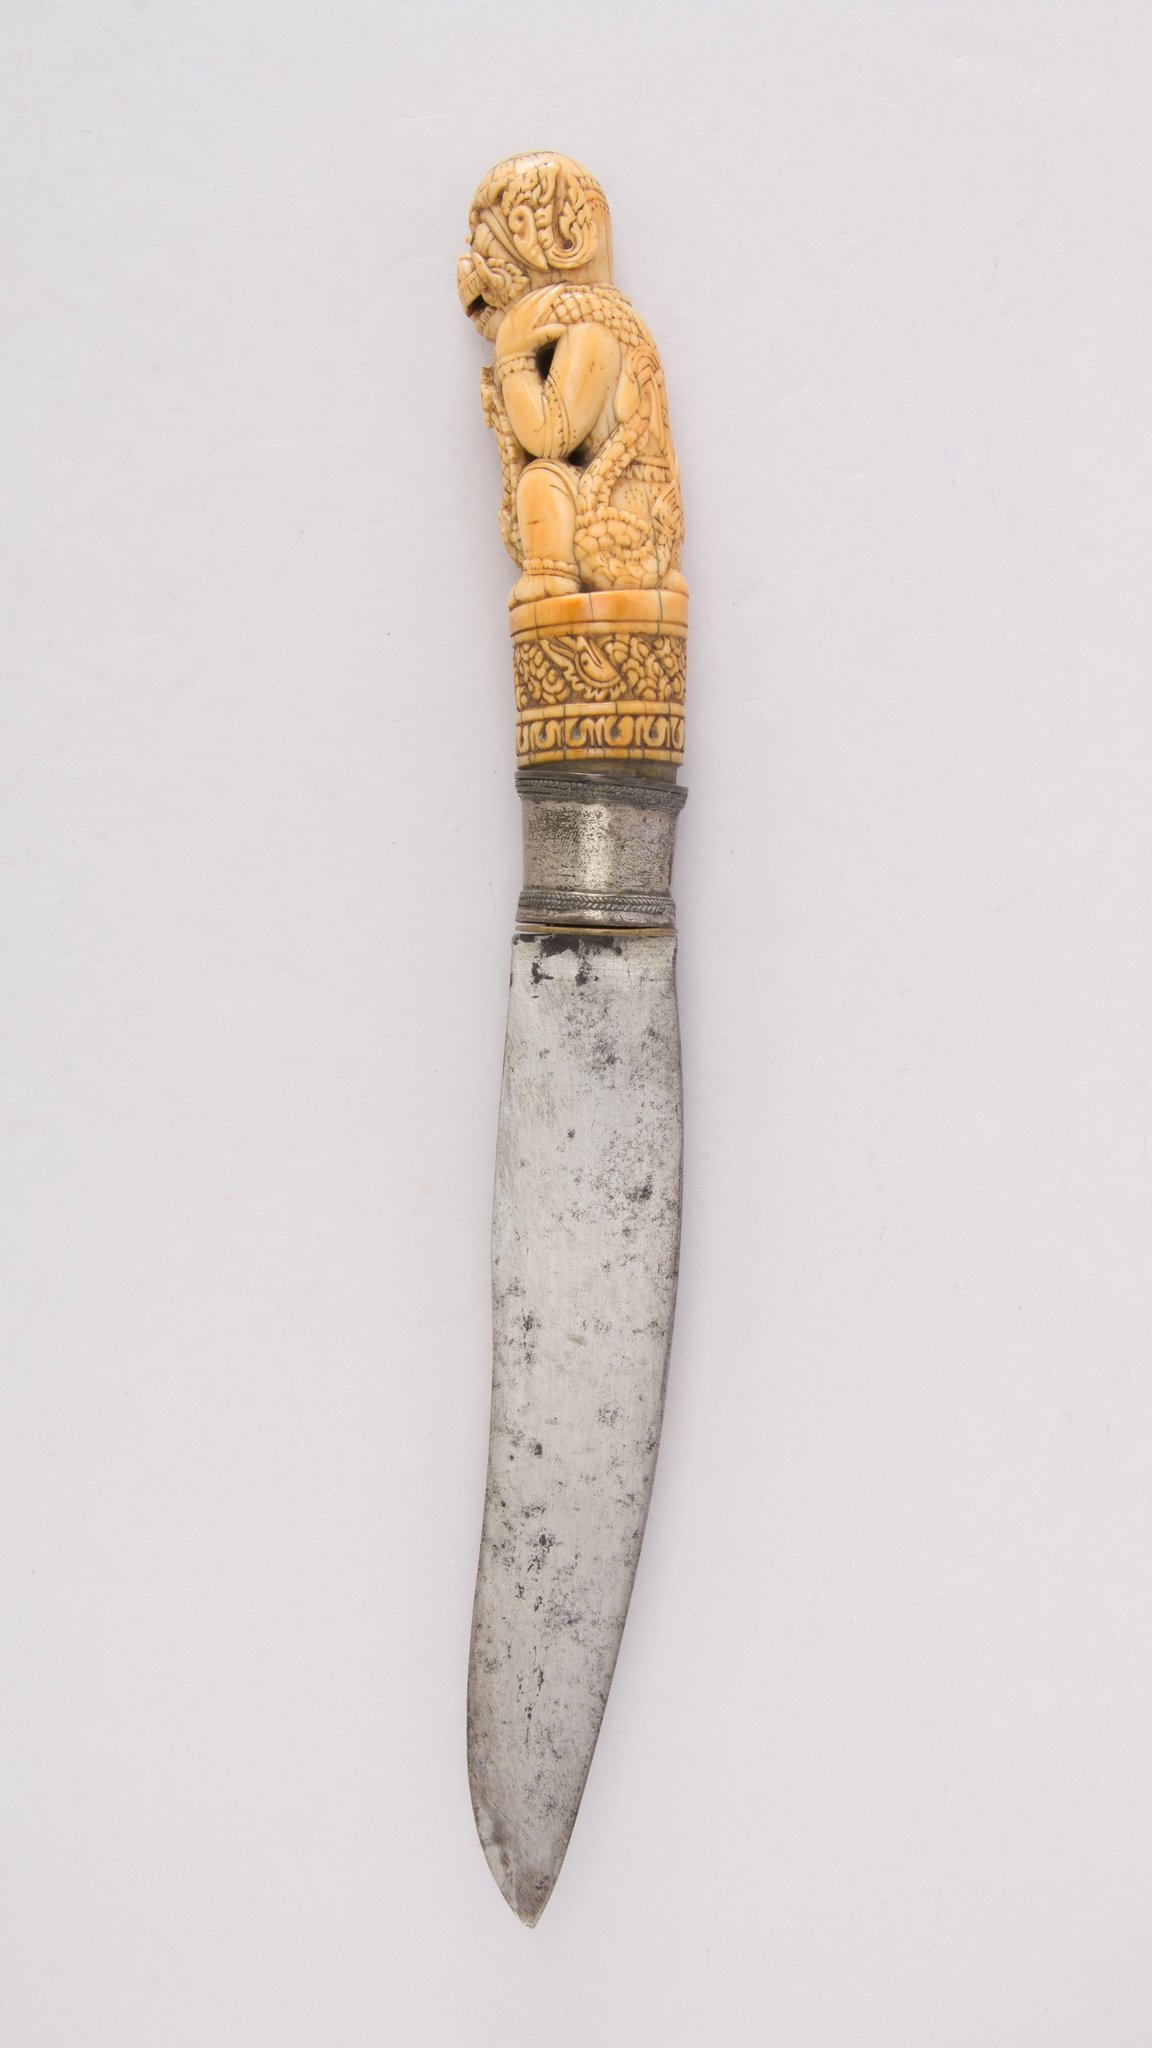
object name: dagger dha or dah hmyaung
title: Dagger (Dha or Dah Hmyaung)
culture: burmese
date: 1701-1800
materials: ivory, steel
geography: myanmar